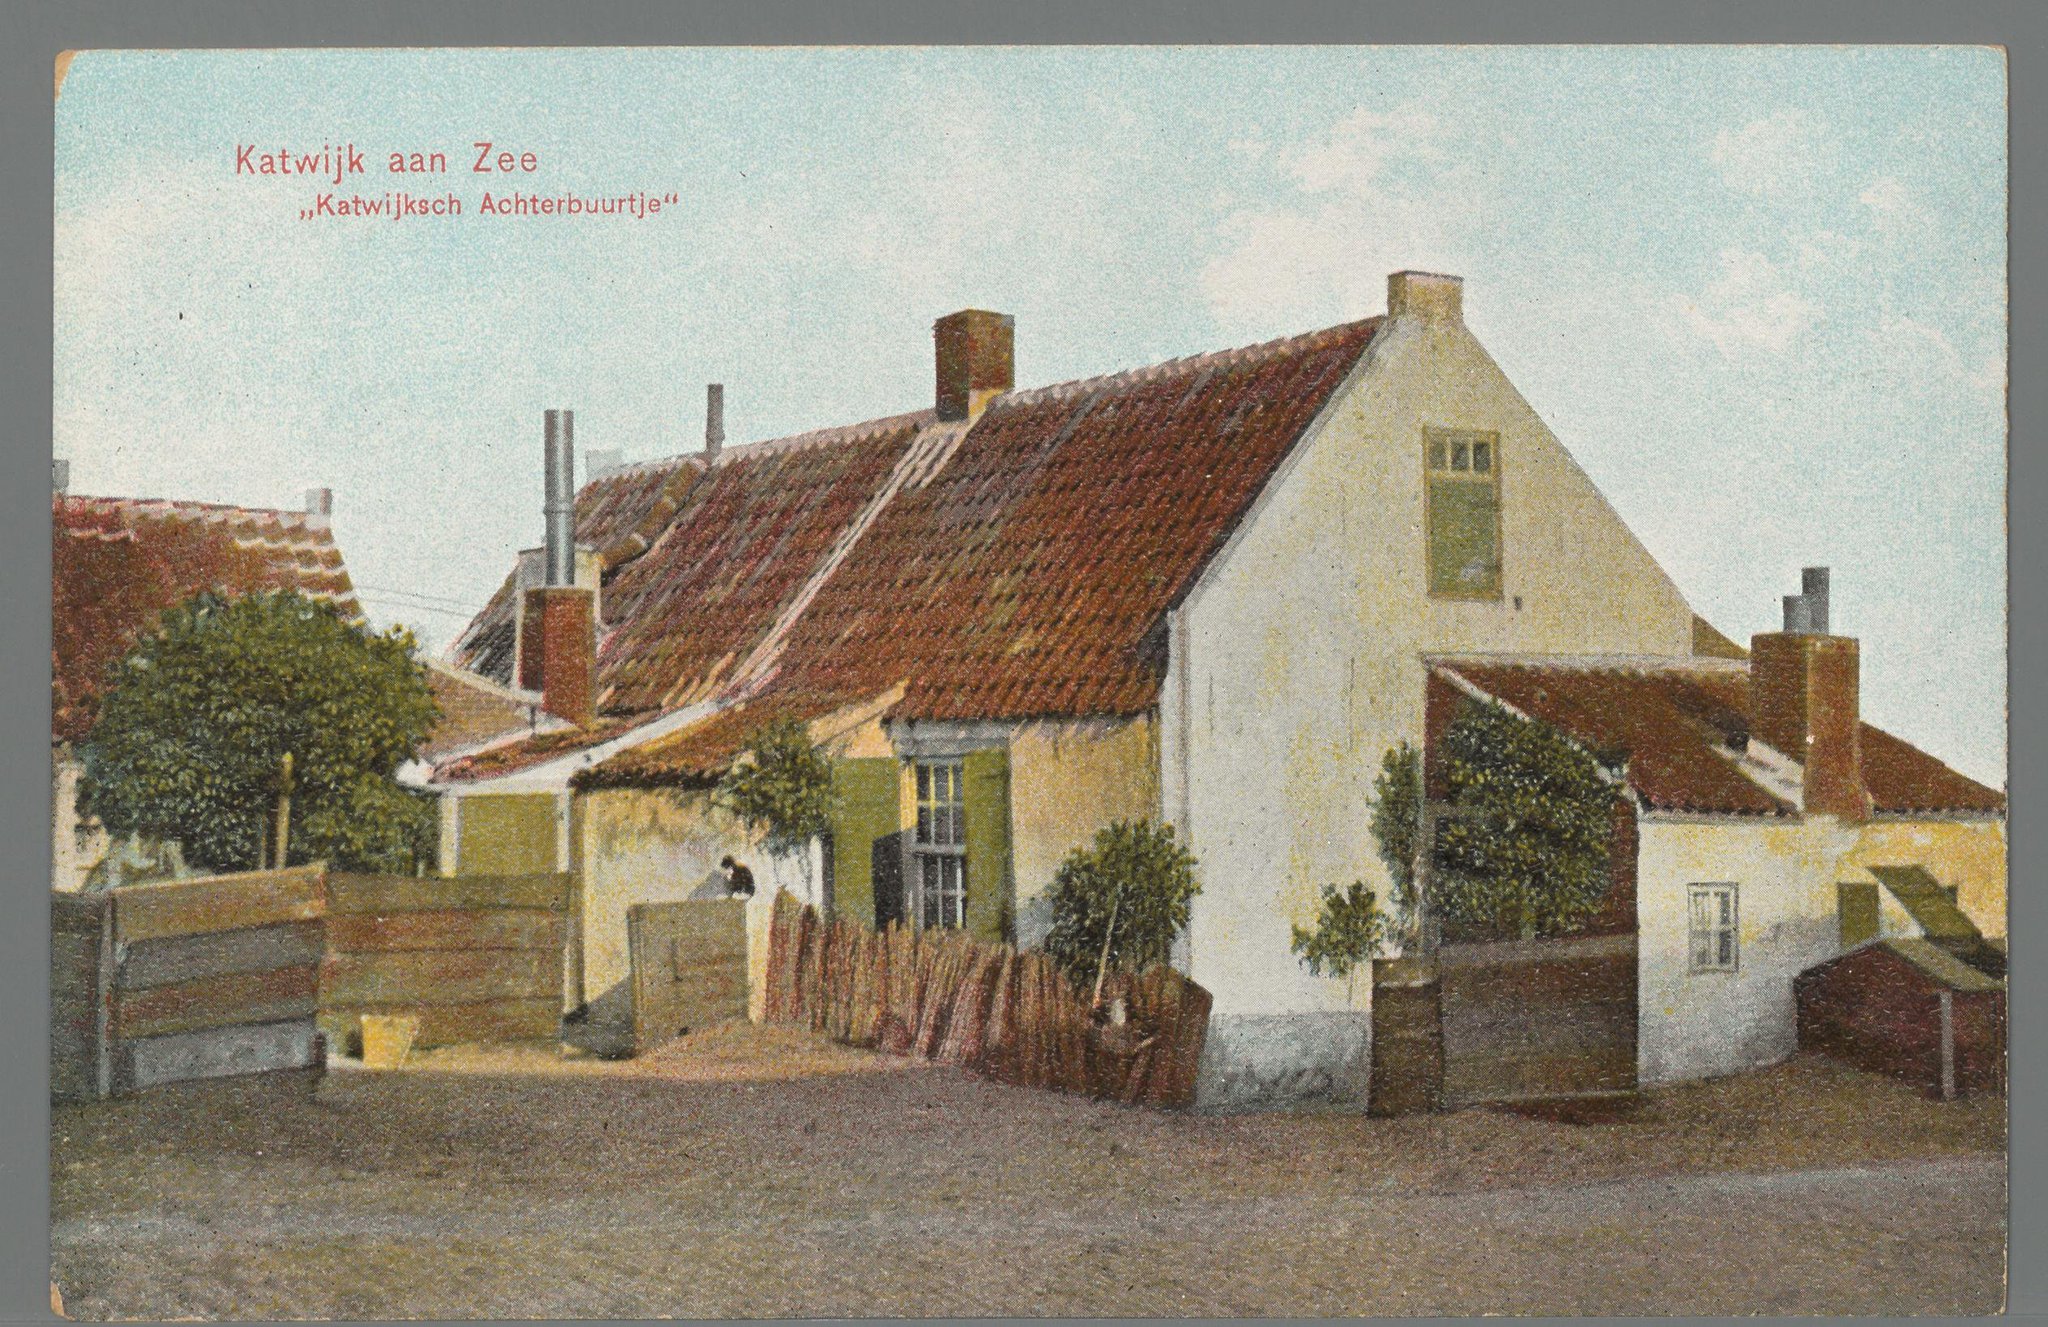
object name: ansichtkaart, prentbriefkaart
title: Katwijk aan Zee. "Katwijksch Achterbuurtje"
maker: Anonymous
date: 1905-1930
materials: cardboard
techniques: lithograph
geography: katwijk aan zee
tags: housing